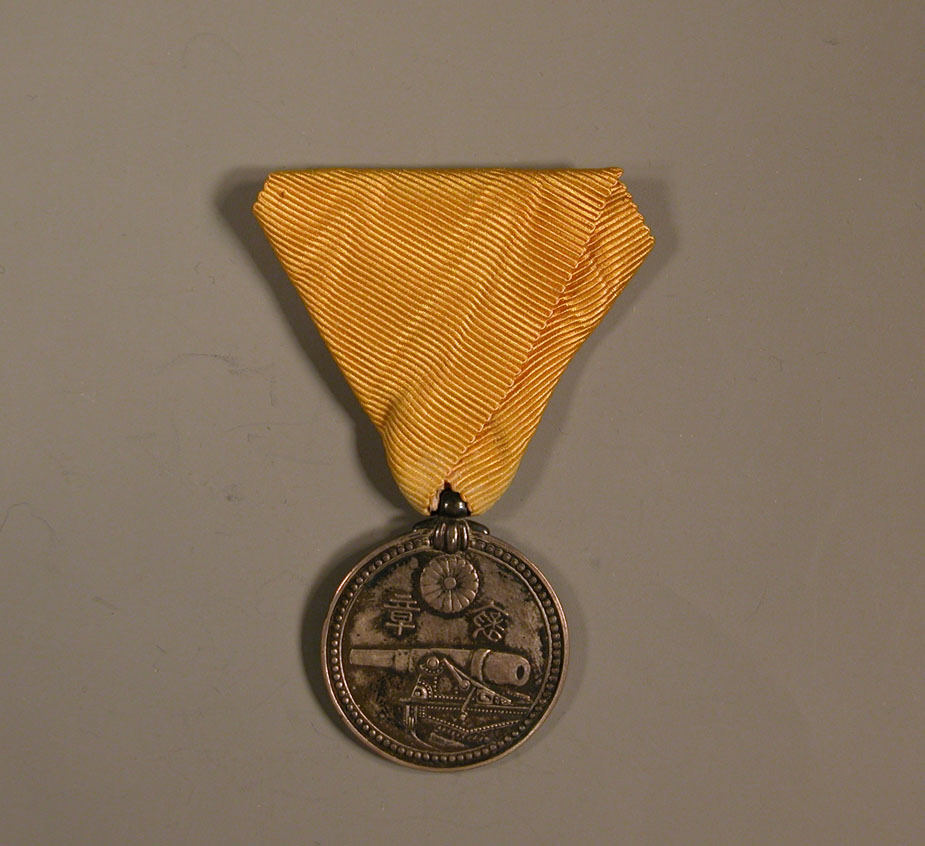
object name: medal of honor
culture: japanese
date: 1867-1900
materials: ribbon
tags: cannons